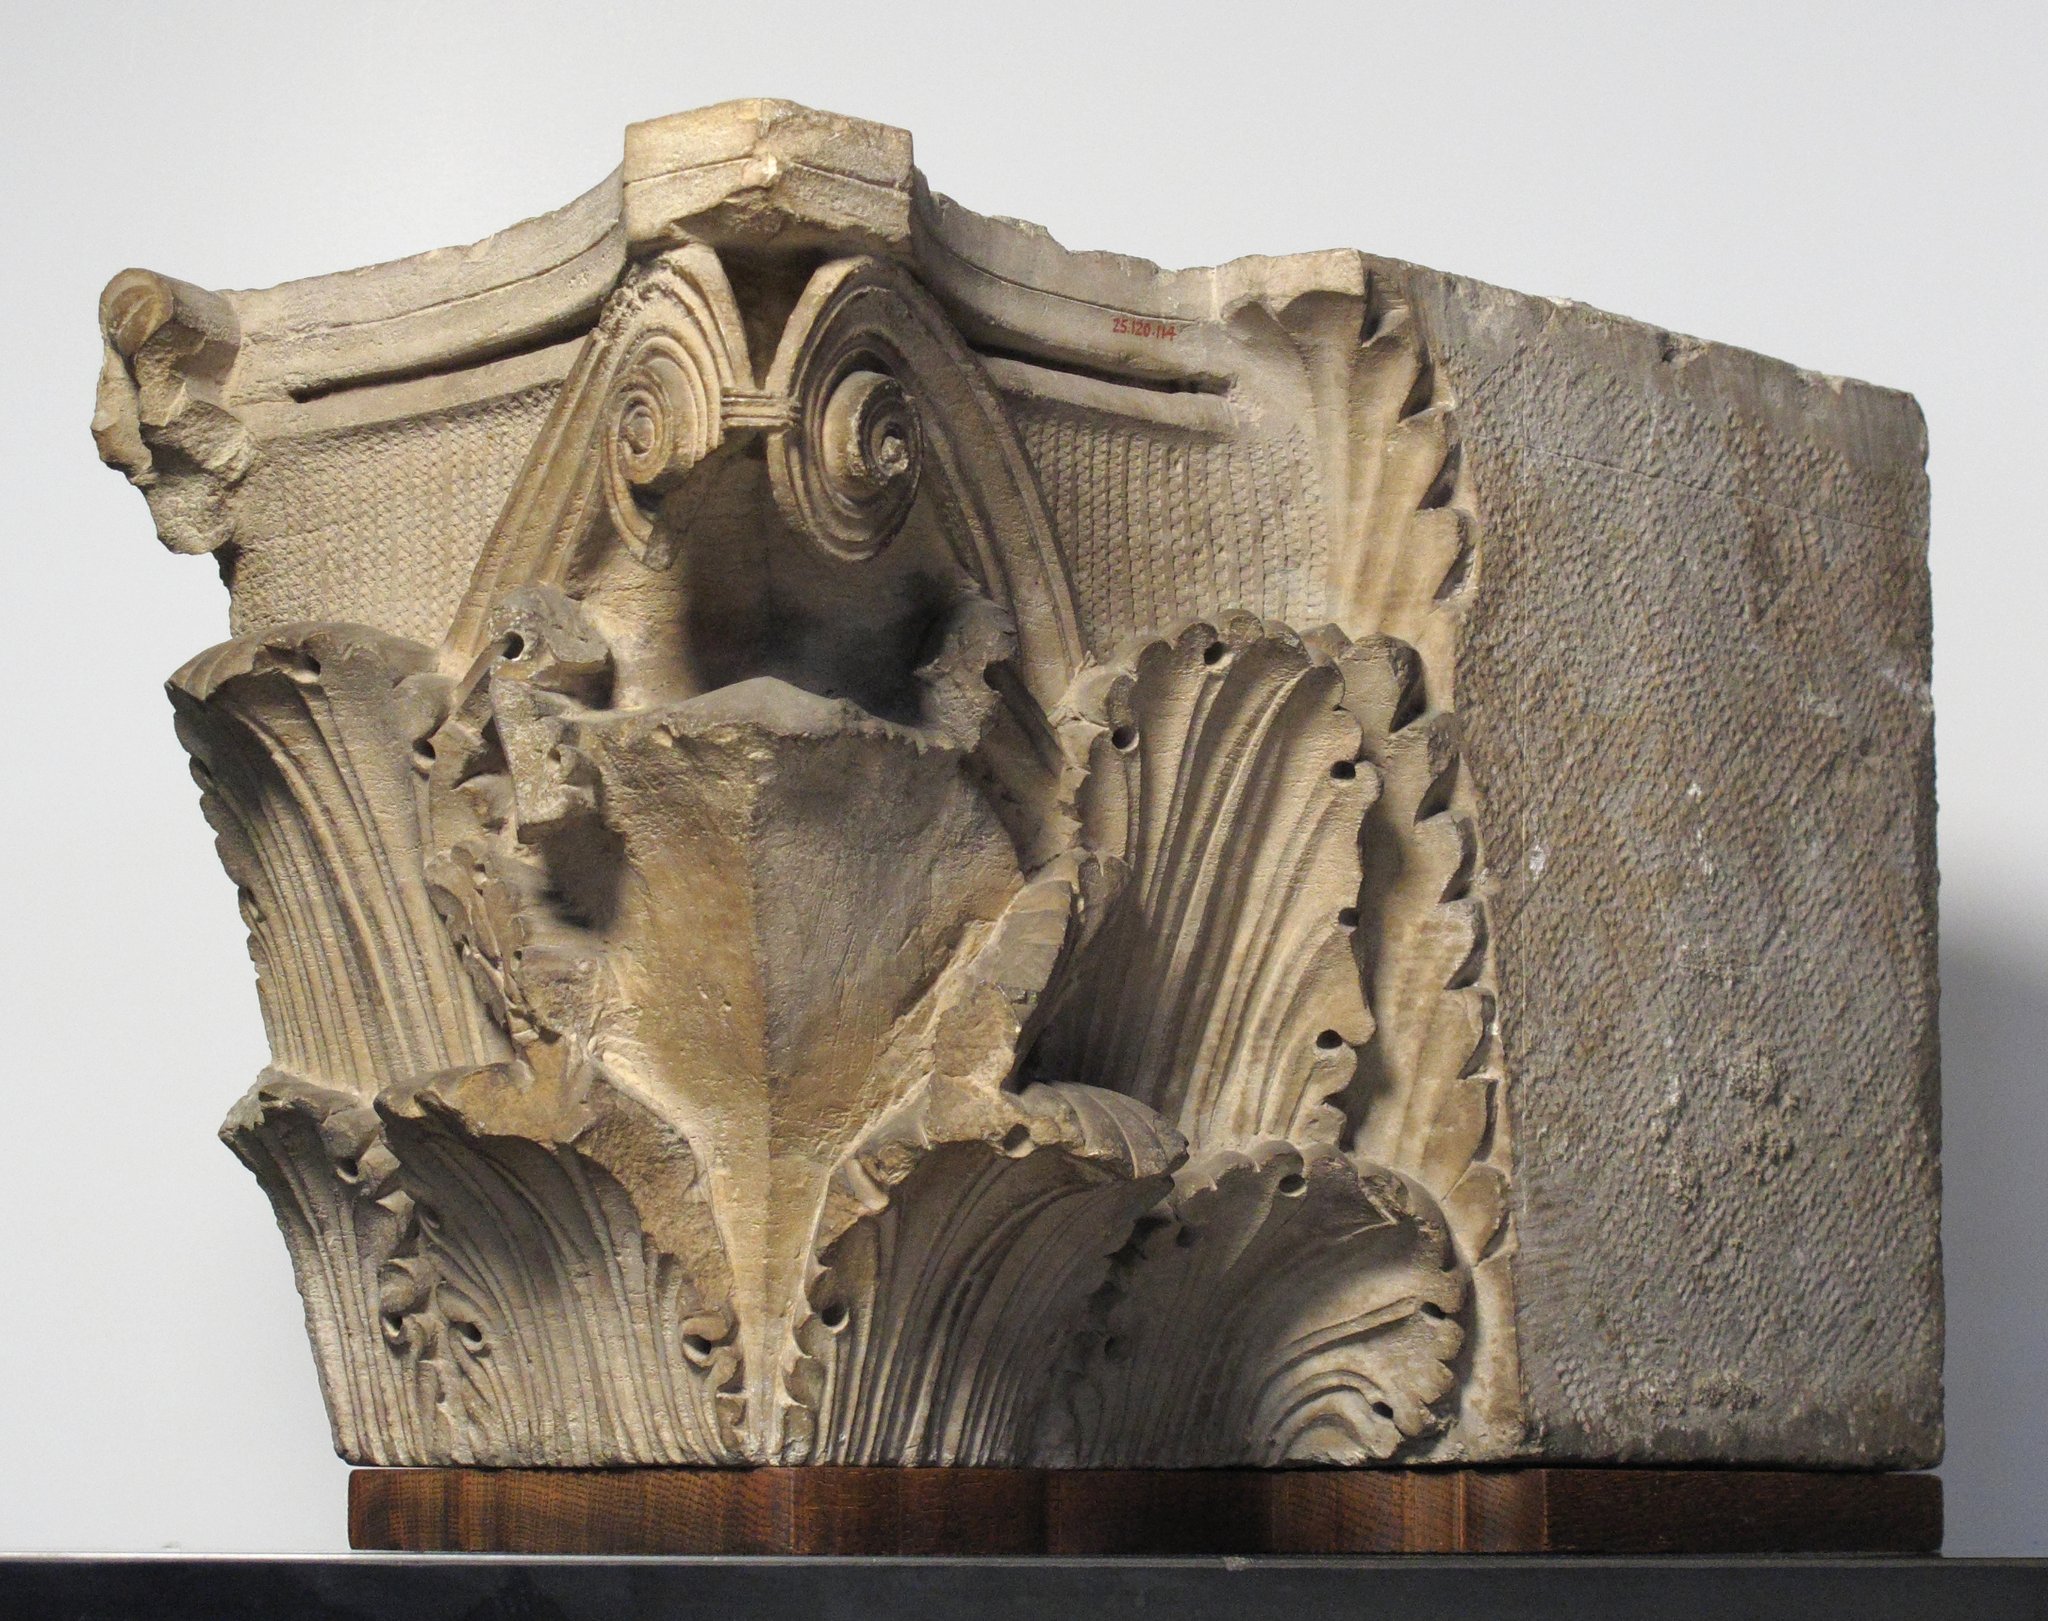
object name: capital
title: Engaged Capital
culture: south french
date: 1167-1200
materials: stone